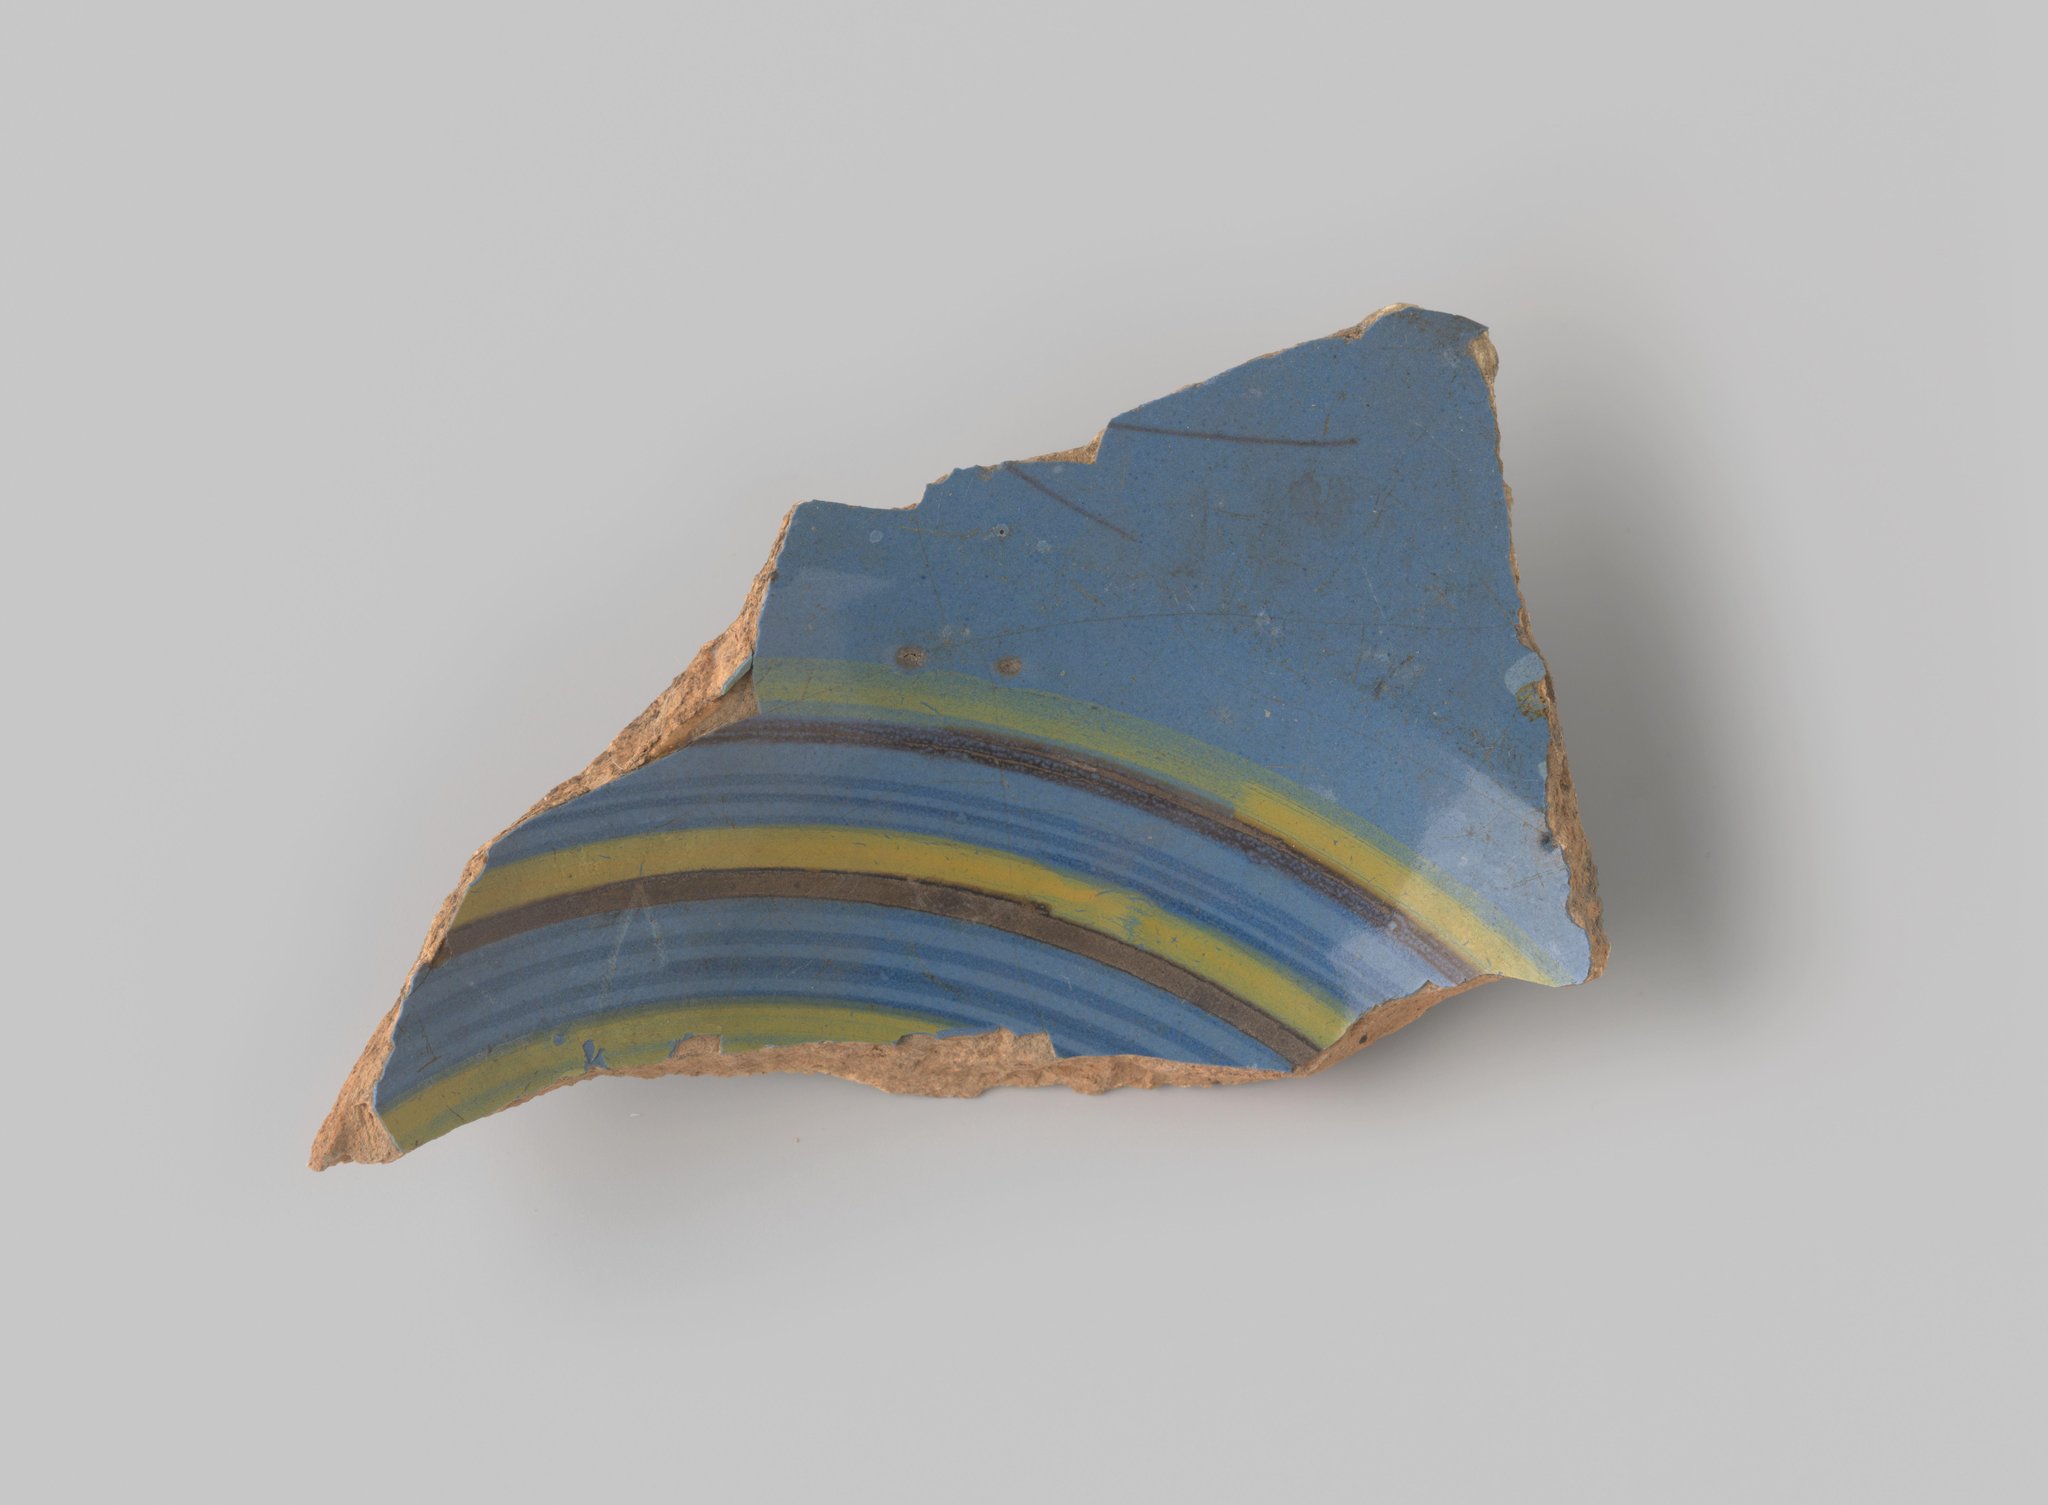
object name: fragment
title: Scherf van roodbakkend aardewerk, aan de bovenzijde voorzien van blauw glazuur met decoratie van strepen in bruin, geel en groen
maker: Anonymous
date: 1600-1650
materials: earthenware, glaze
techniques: maiolica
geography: northern netherlands